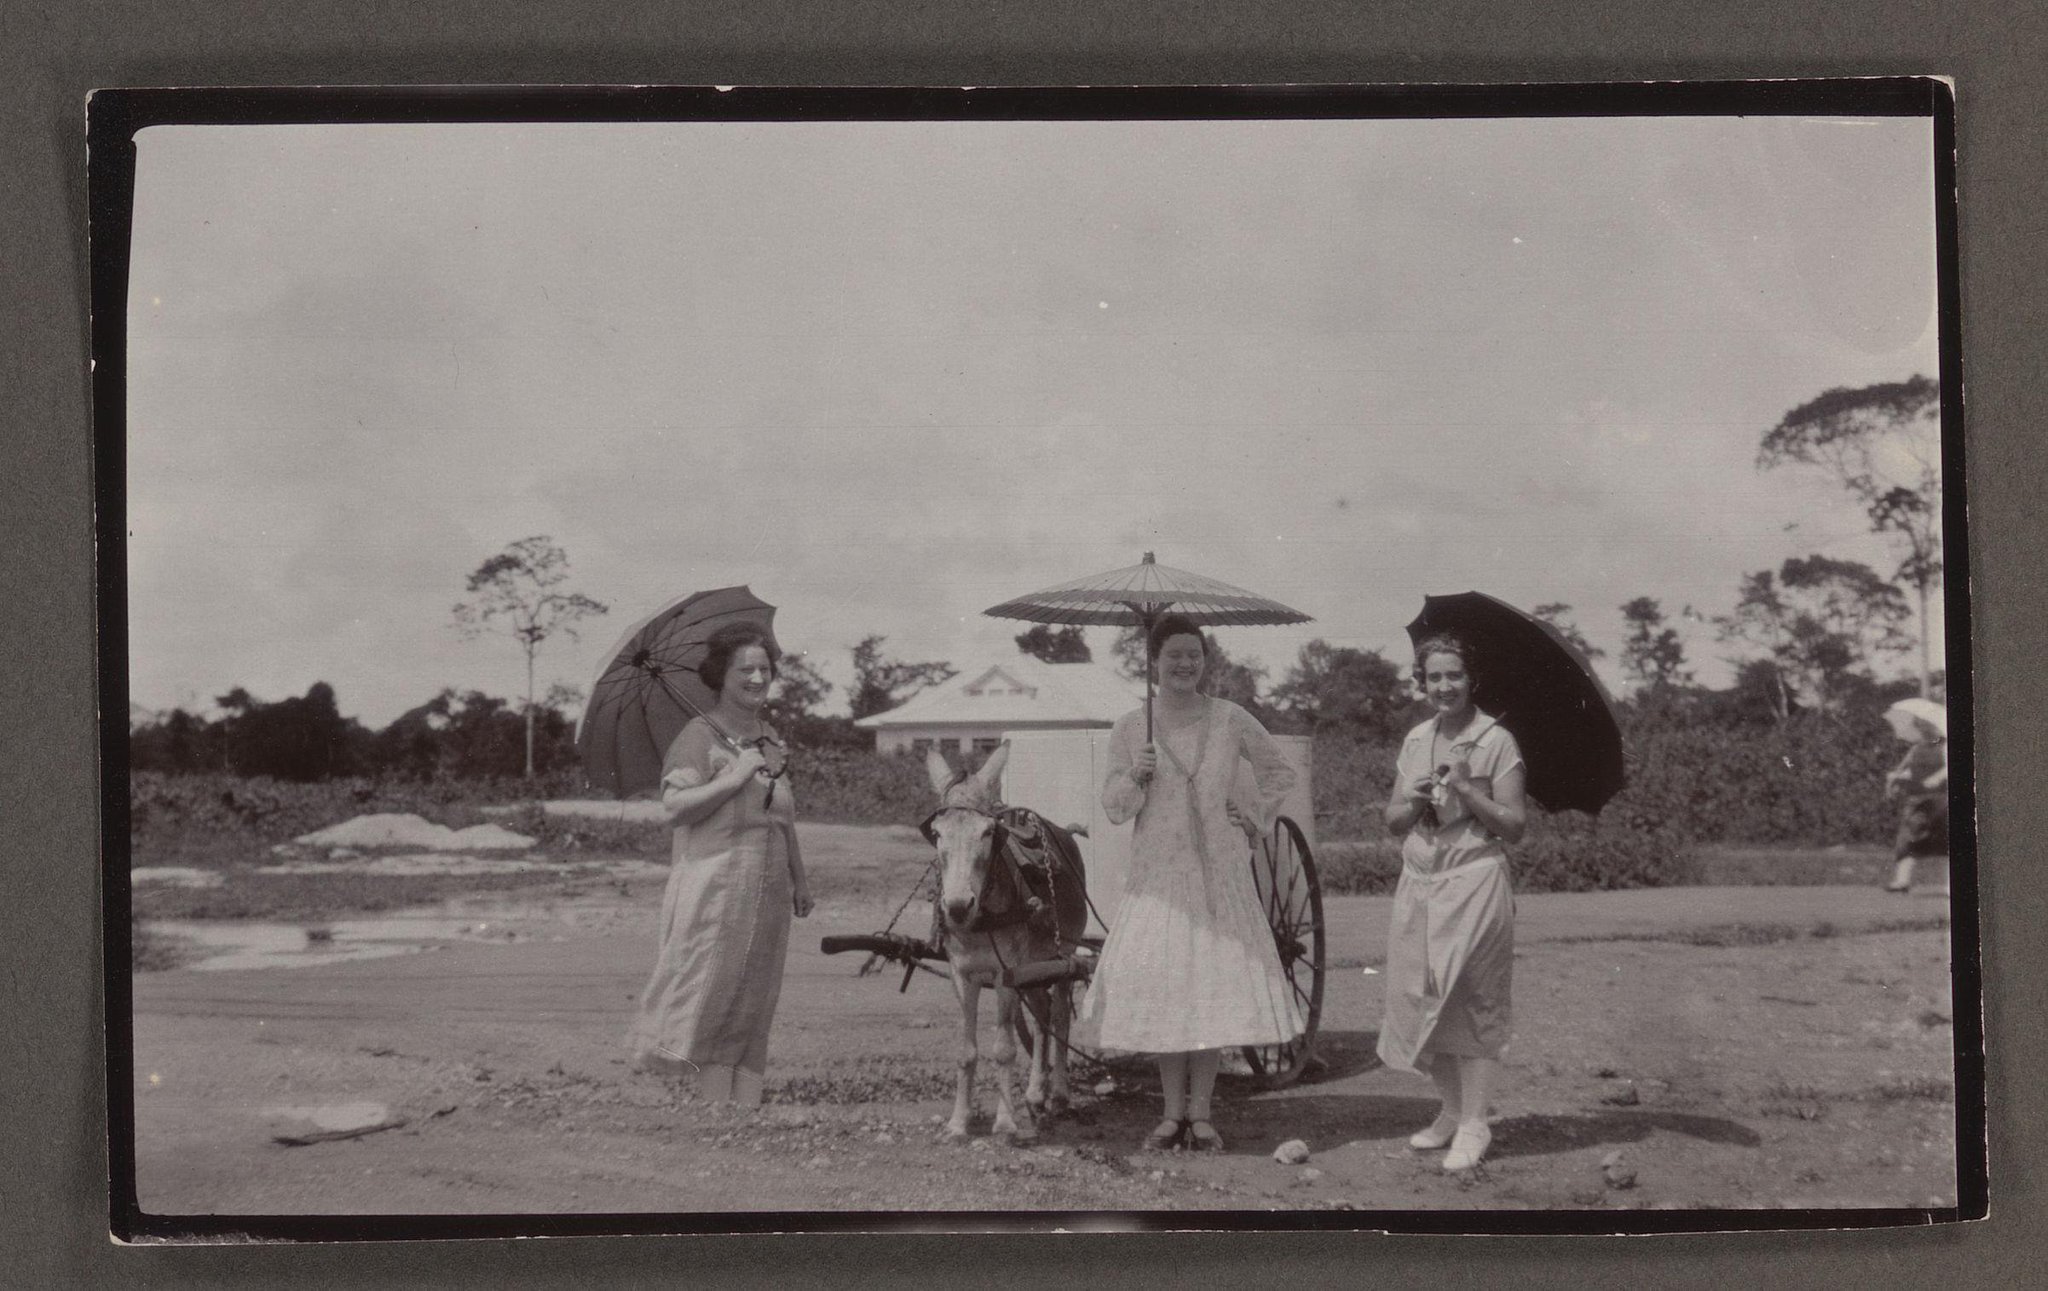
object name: photograph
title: Familiefoto van de kinderen Jetten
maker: Anonymous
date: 1925-1927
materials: photographic support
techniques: photography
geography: suriname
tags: jetten, familie, moengo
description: Familiefoto van de kinderen Jetten. Foto op een bladzijde van een los albumblad. Onderdeel van het ensemble met foto's van de familie van ingenieur Jetten in de mijnbouwstad Moengo in Suriname.